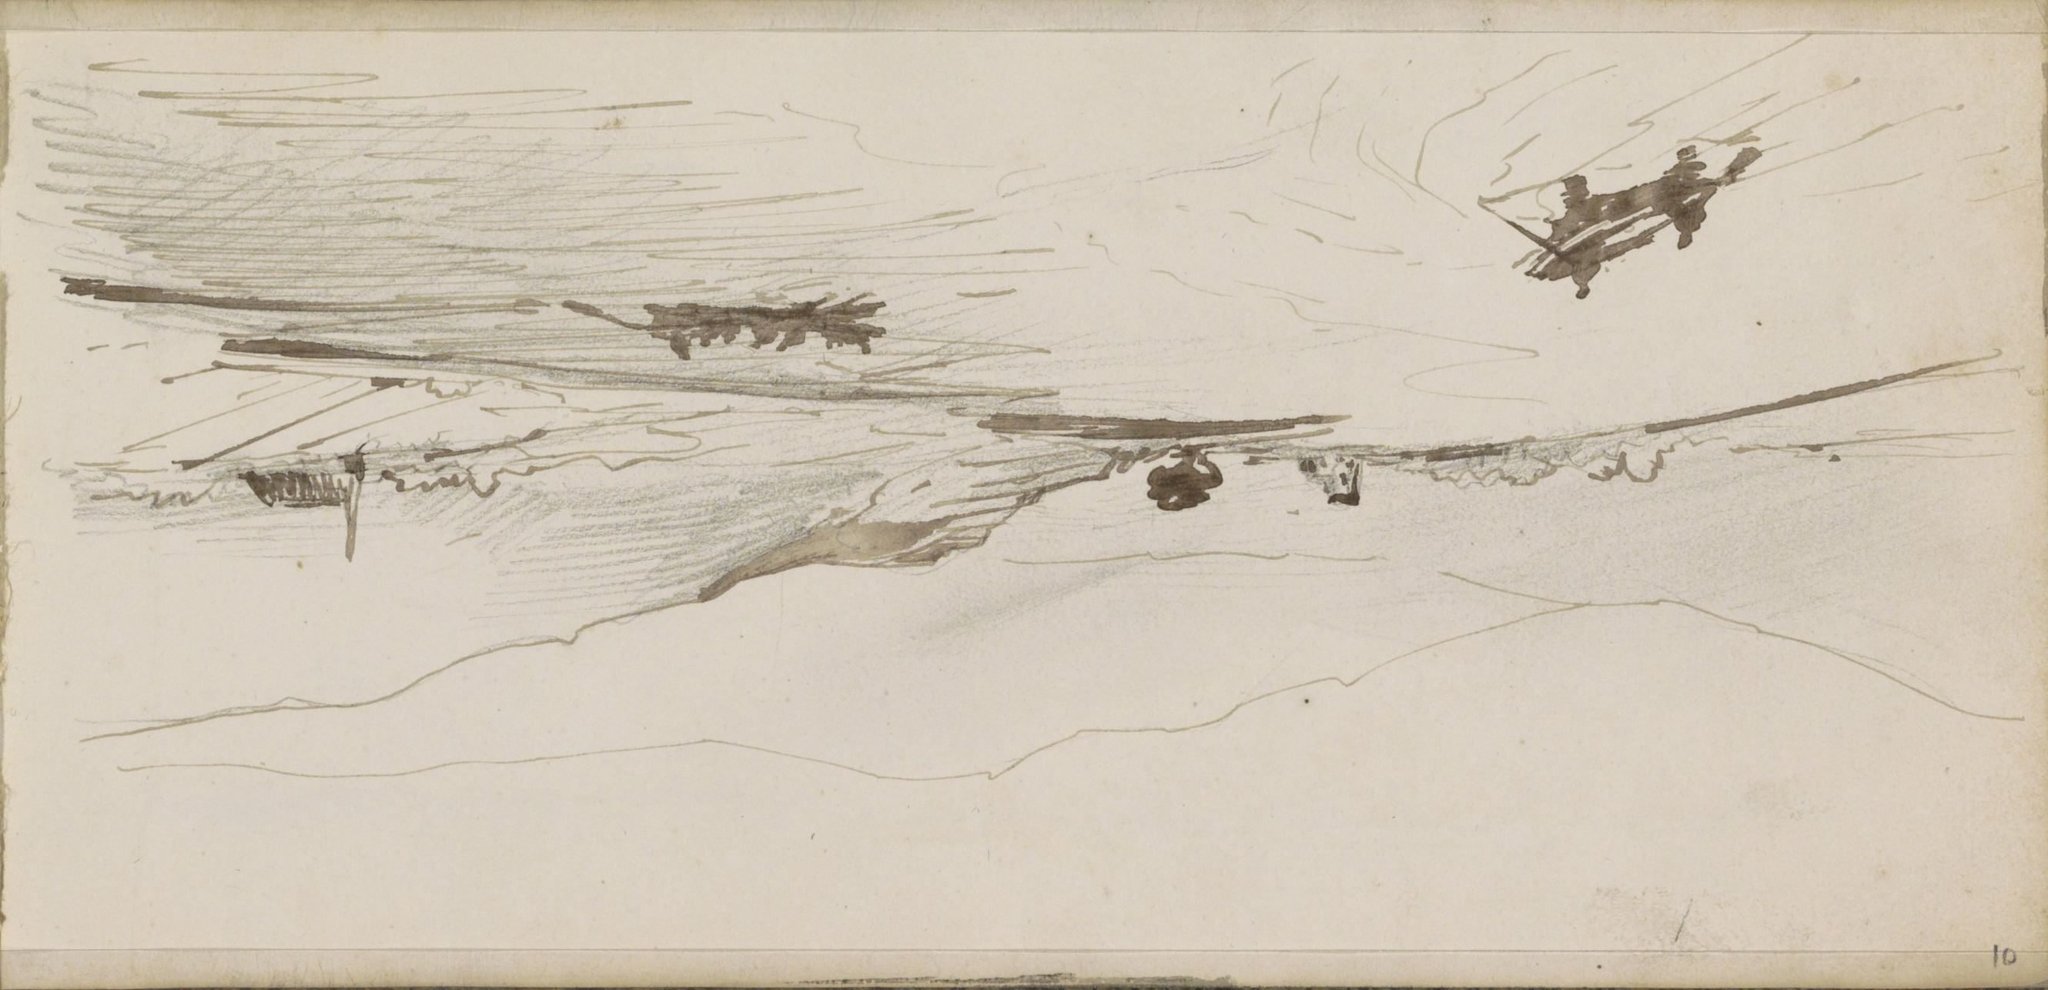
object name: sketchbook leaf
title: Berglandschap met roeiboten op een meer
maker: johannes tavenraat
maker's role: draughtsman, painter, print maker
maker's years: 1809-1881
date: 1840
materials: ink, paper, pencil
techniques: pen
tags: landscapes with waters, waterscapes, seascapes (in the temperate zone), rowing-boat, canoe, etc., mountains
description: Blad 10 recto uit een schetsboek met 63 bladen.